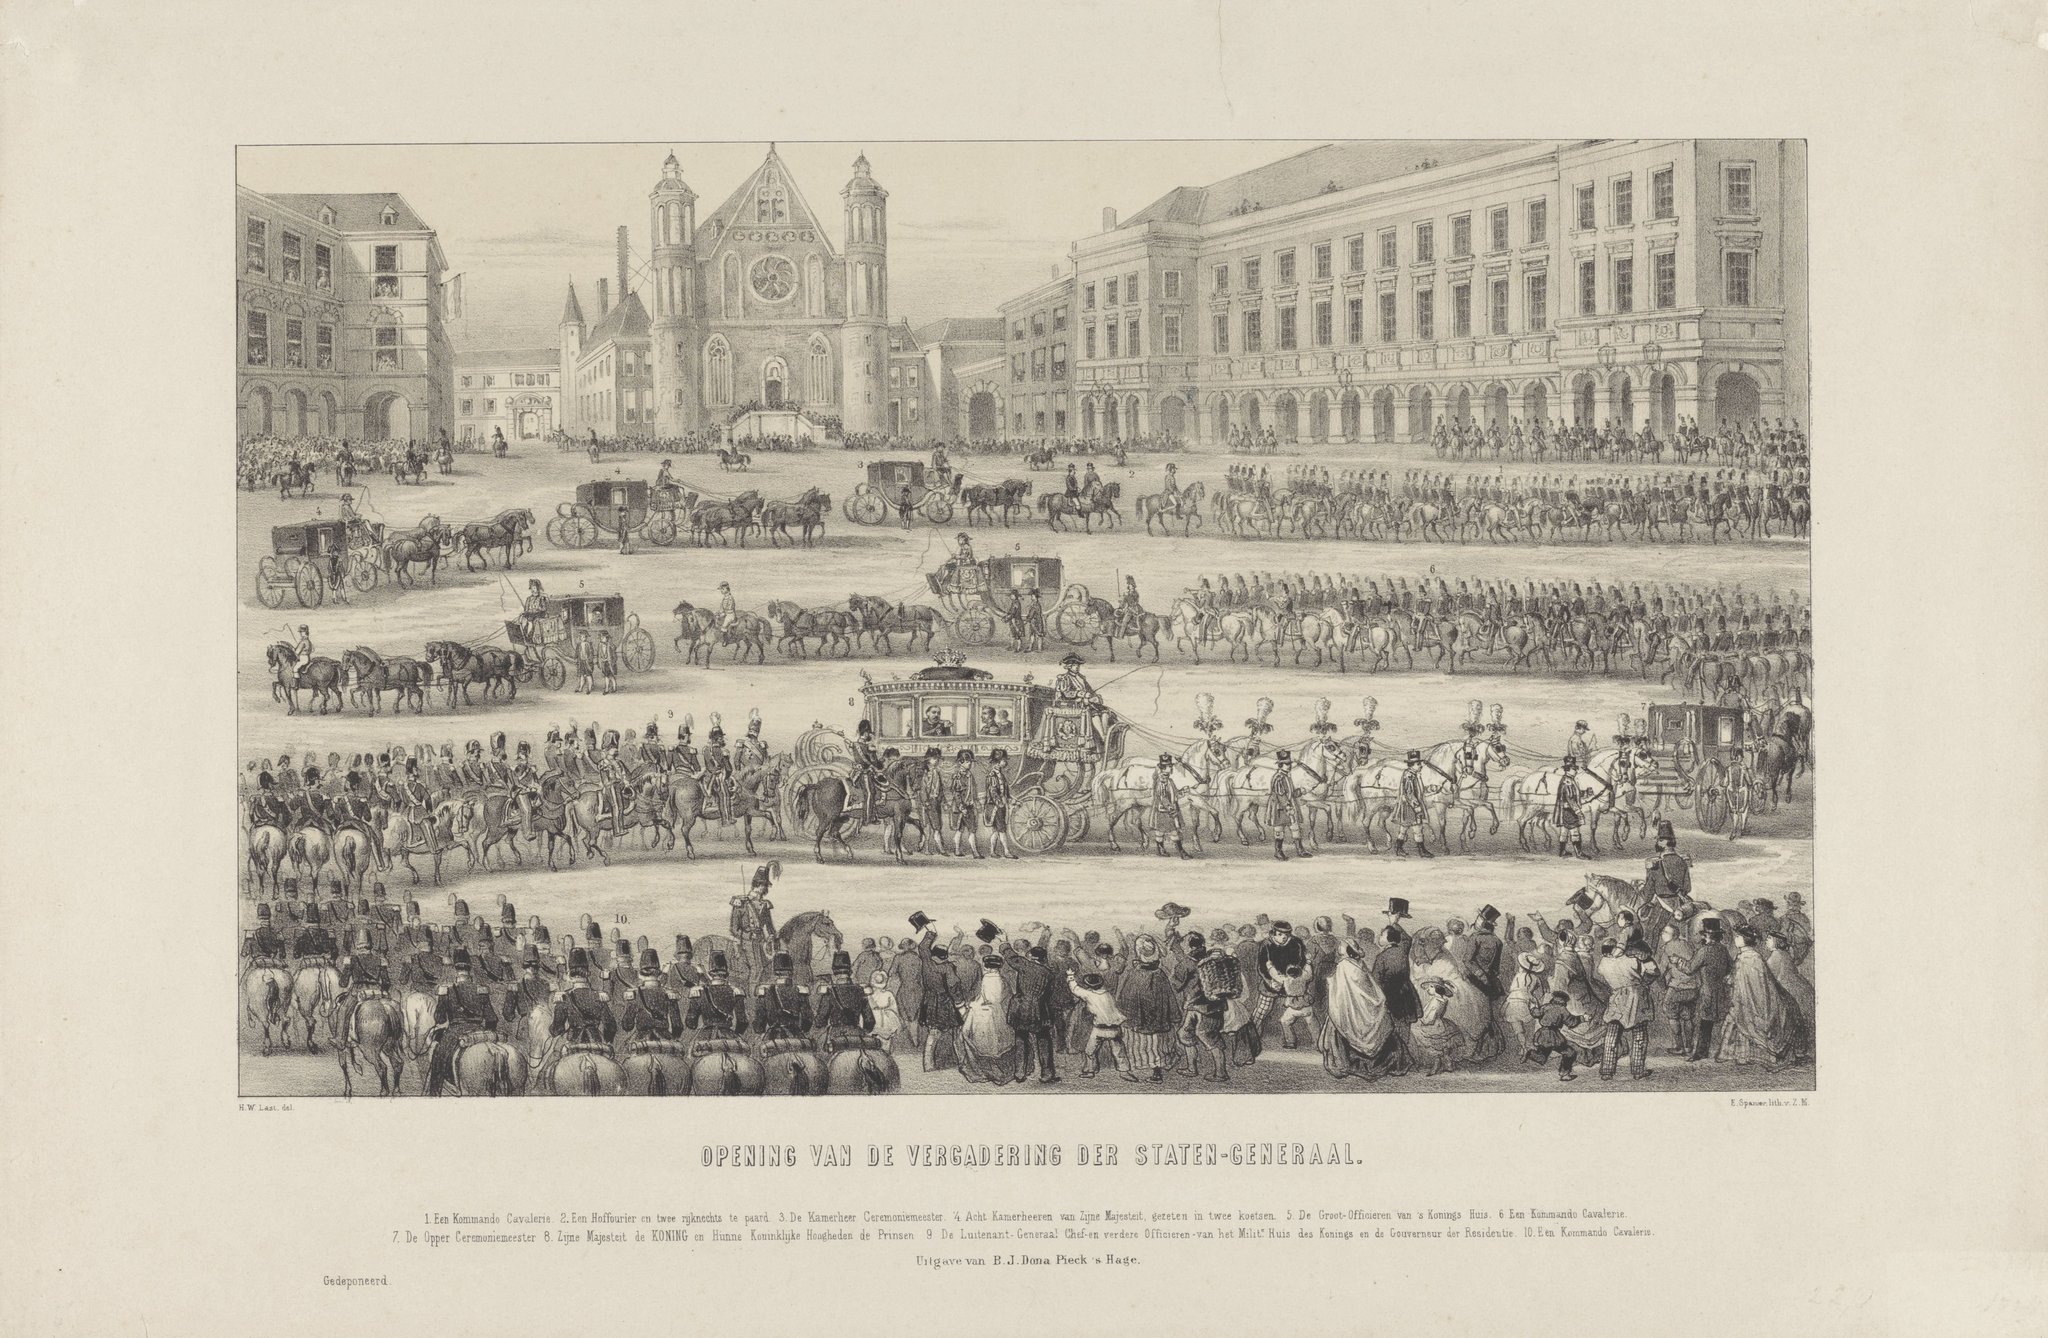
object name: print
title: Opening Staten Generaal, 1864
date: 1864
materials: paper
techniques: tone lithography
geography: the hague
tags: willem iii (koning der nederlanden), official acts of rulers, e.g. royal acts (ruler giving audience, granting mercy, etc.; ruler and his subjects), lower house, parliament, chamber, the hague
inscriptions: collector's mark: Lugt 2228, : ‘Gedeponeerd’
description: De voorstelling van deze prent is in de beschrijving in het inventarisboek gedateerd 19 september 1864. Waarop dit is gebaseerd is niet duidelijk. De uitgever Elias Spanier die op de prent is vermeld was reeds in april 1863 overleden. Niet in Frederik Muller; door het RPK toegevoegd nummer.